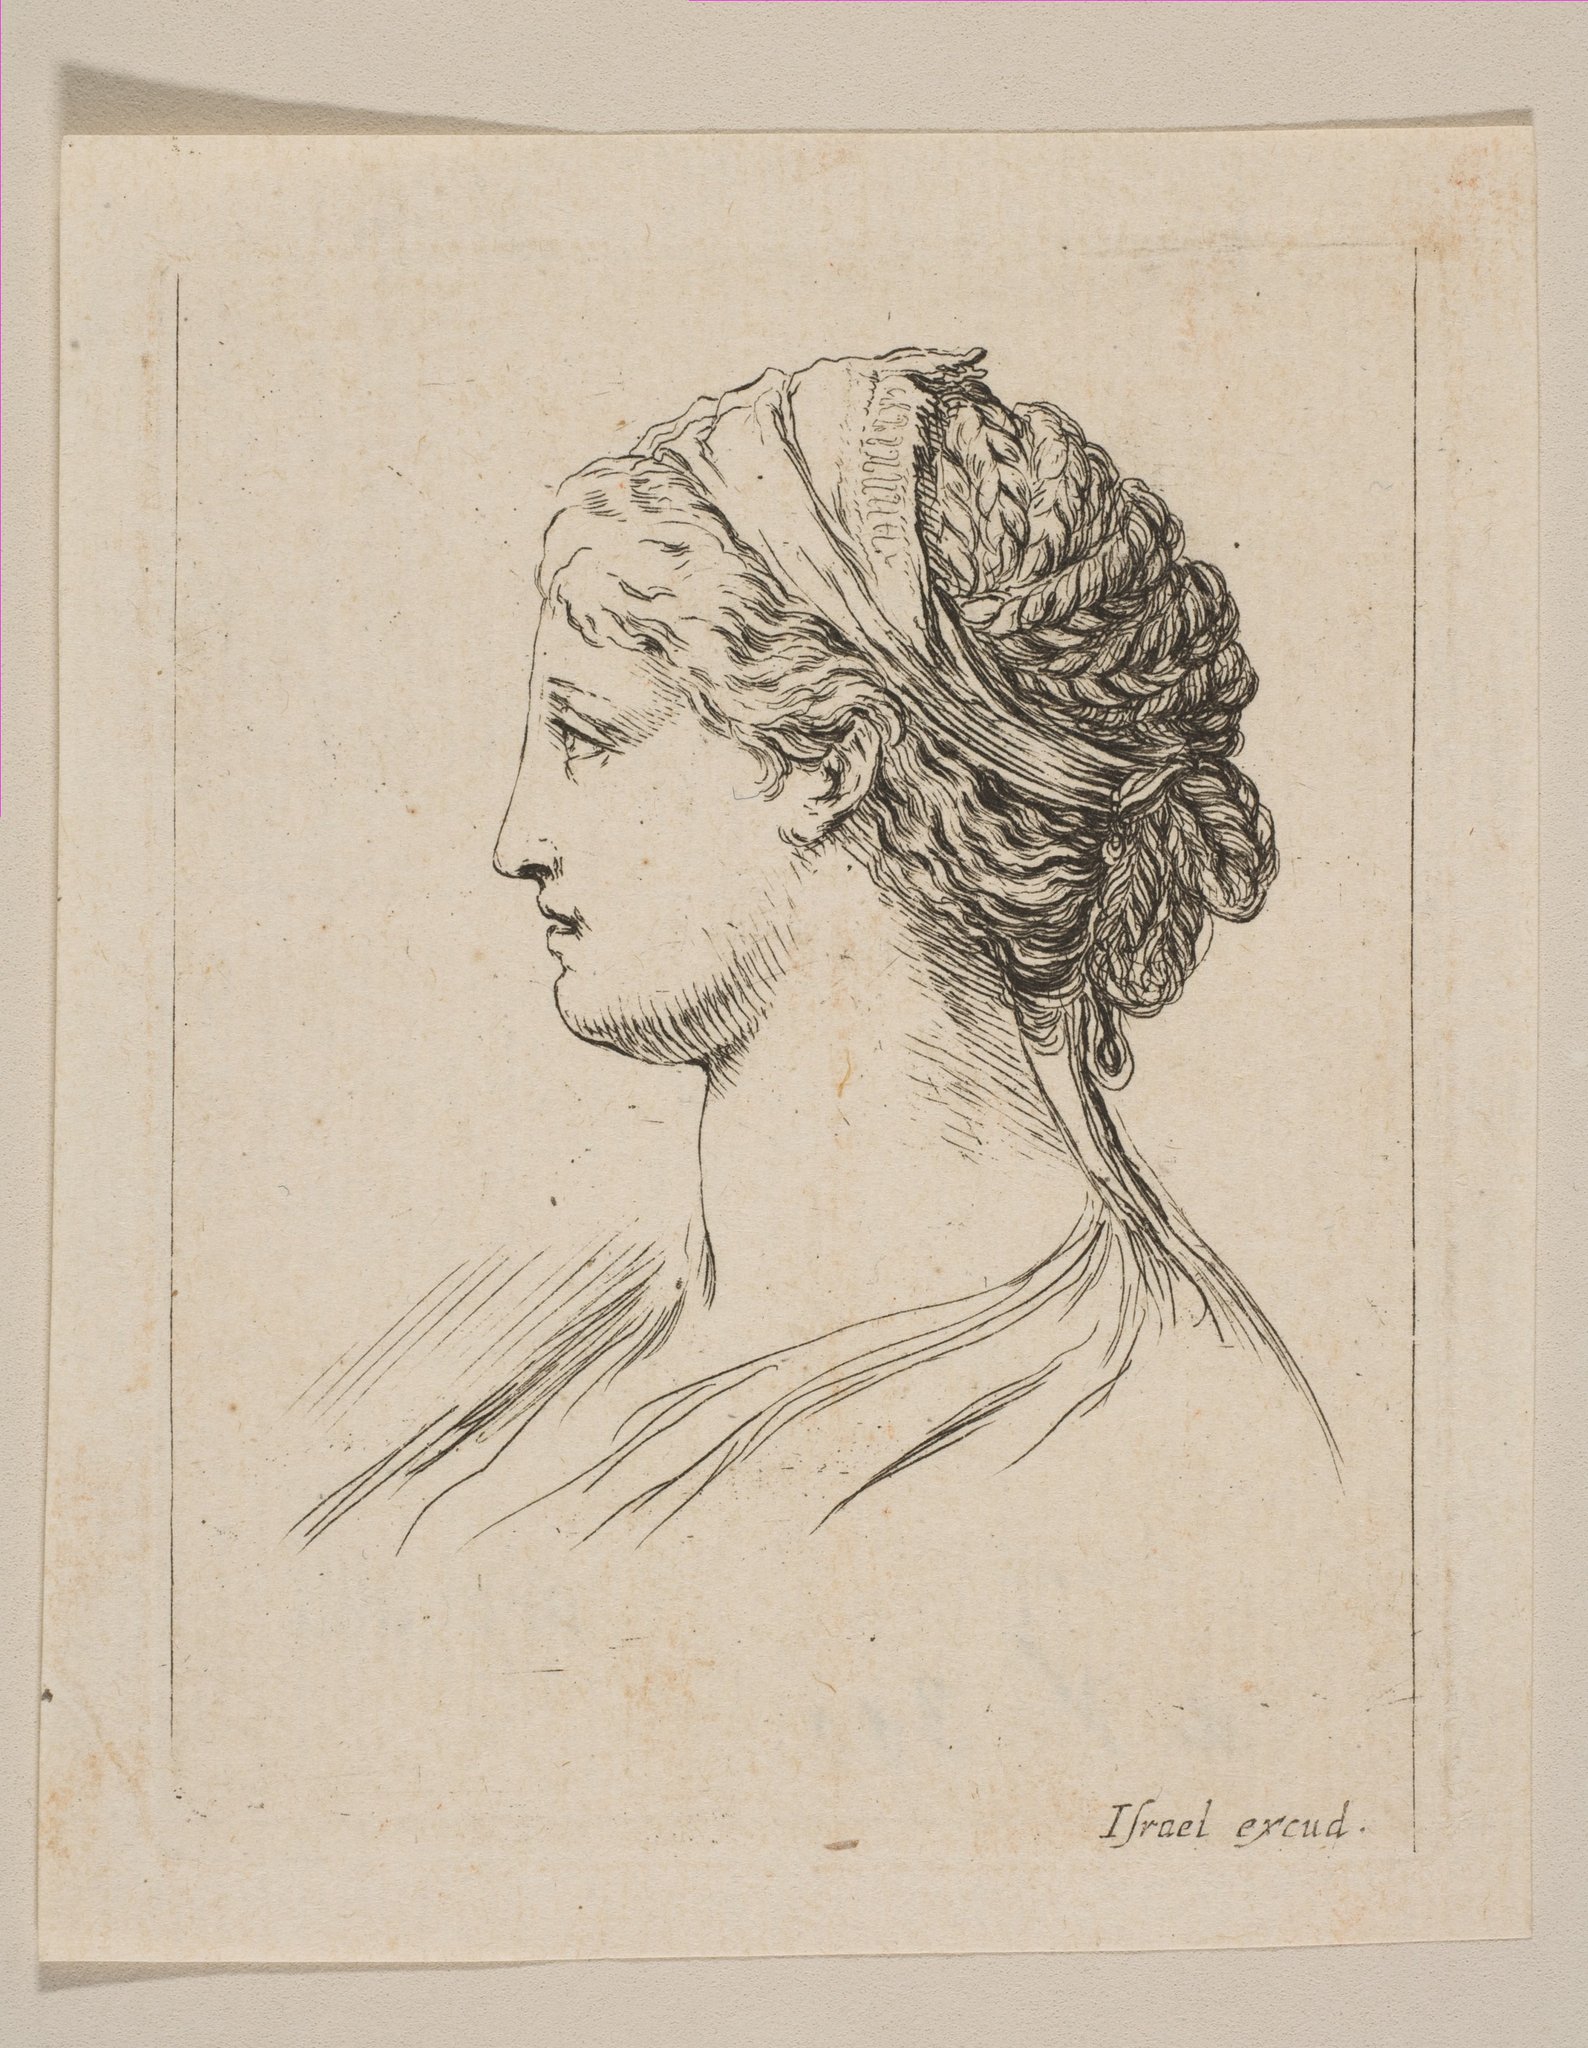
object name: print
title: Head of a Woman in Profile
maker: stefano della bella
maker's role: artist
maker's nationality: italian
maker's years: 1610-1664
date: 1650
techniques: etching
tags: heads,profiles,women